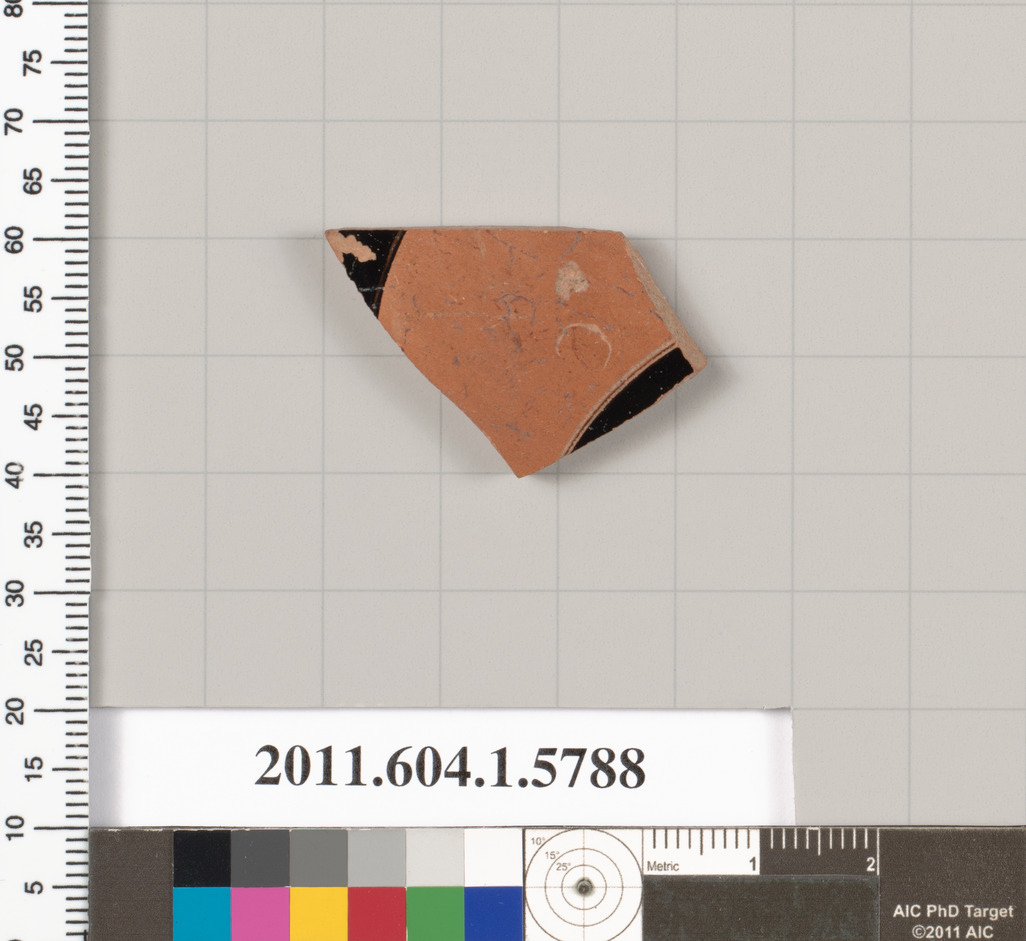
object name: kylix fragment, eye cup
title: Terracotta fragment of a kylix: eye-cup (drinking cup)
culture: greek, attic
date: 525-510 BCE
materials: terracotta